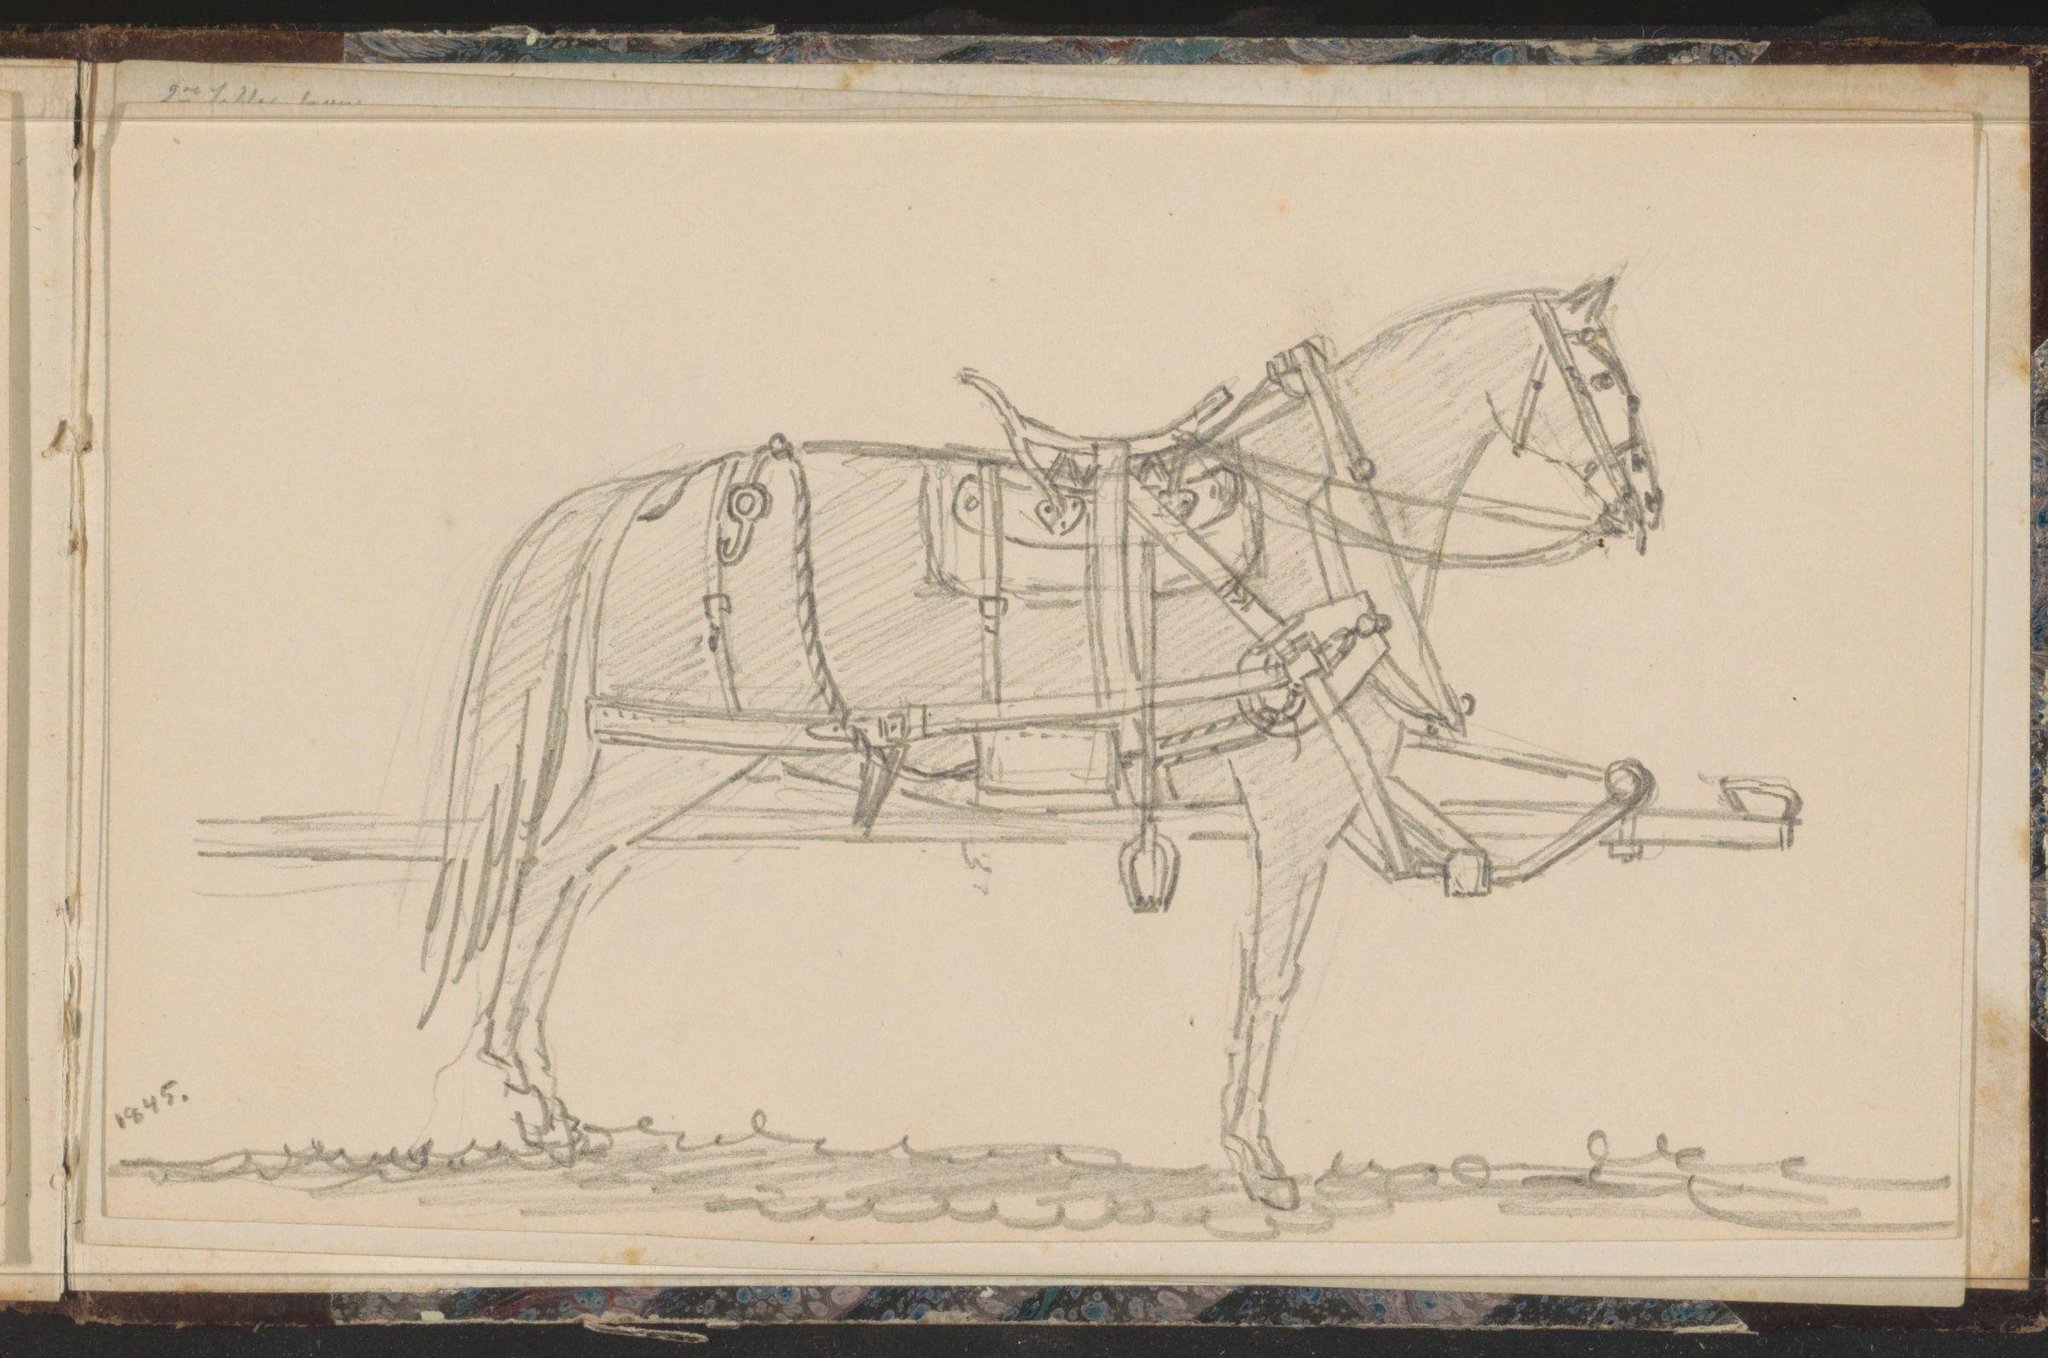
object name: sketchbook leaf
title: Paard met tuig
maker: christian heinrich gottlieb steuerwald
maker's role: draughtsman, print maker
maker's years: 1802-1874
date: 1845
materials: paper, pencil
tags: saddle and bridle (saddlery), horse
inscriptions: date: ‘1845.’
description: Losse tekening tussen blad 61 en het achterste schutblad uit een schetsboek met 61 bladen.